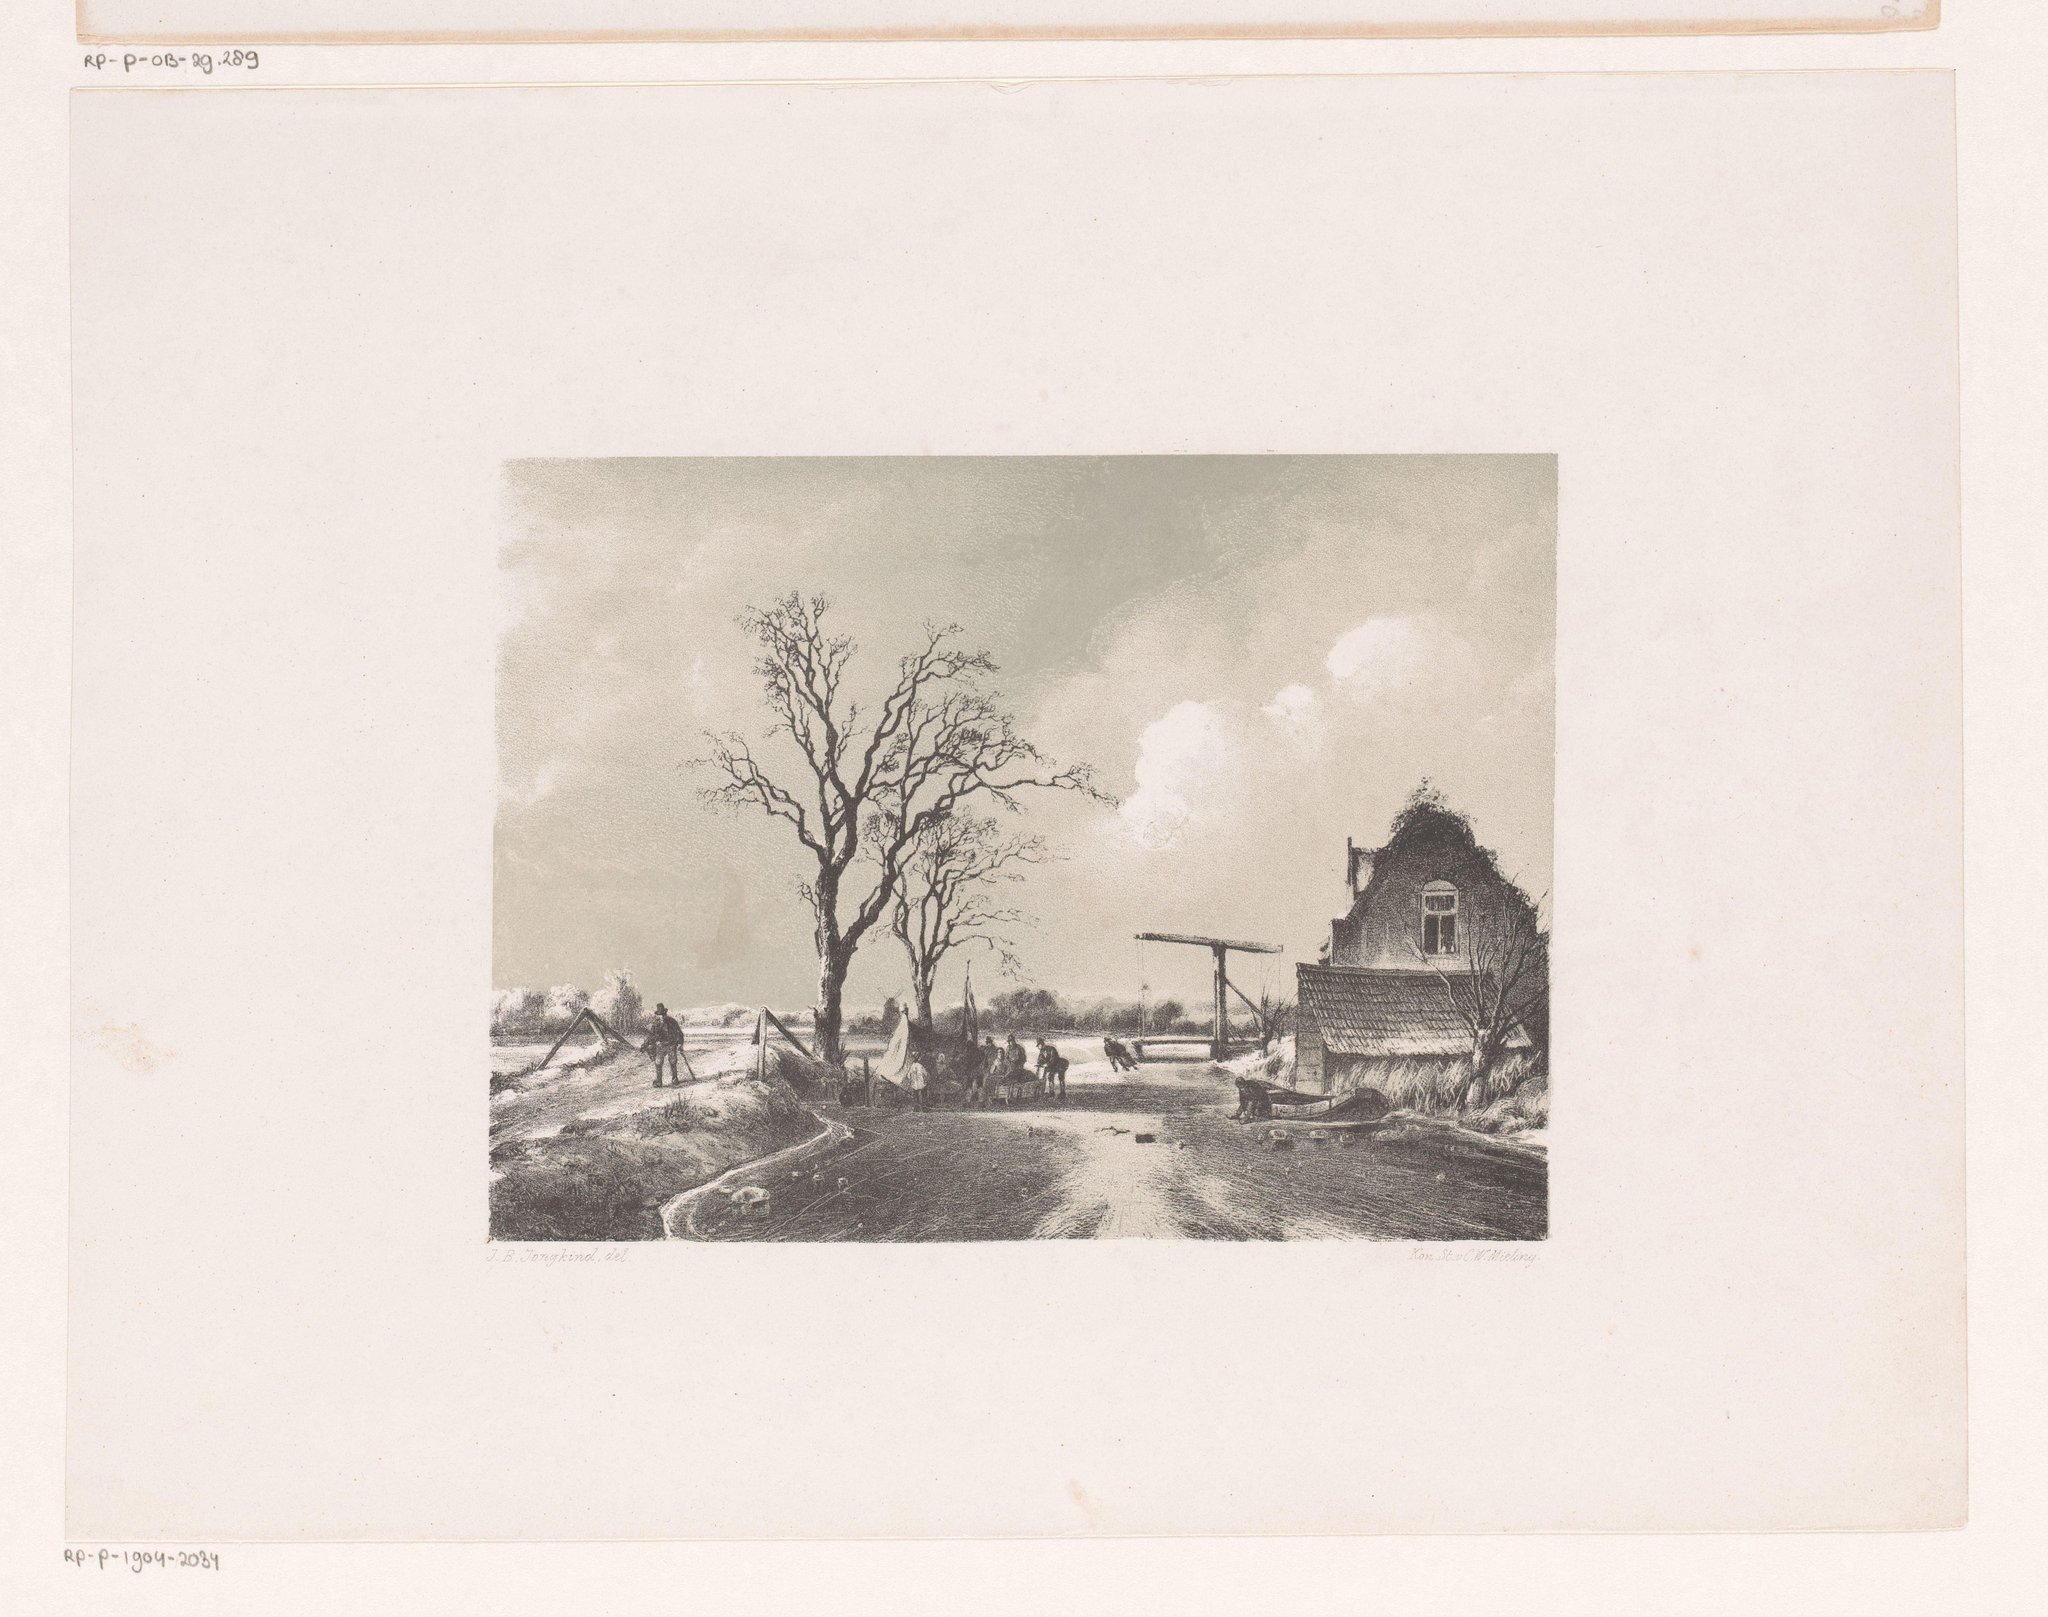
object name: print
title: Bevroren rivier met koek en zopie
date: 1847-1865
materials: paper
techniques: tone lithography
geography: the hague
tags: frost, freezing weather, skates (winter sports), farm or solitary house in landscape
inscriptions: collector's mark: Lugt 2228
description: Bij de koek en zopie staan schaatsers. In de verte een ophaalbrug. Rechts een woonhuis.